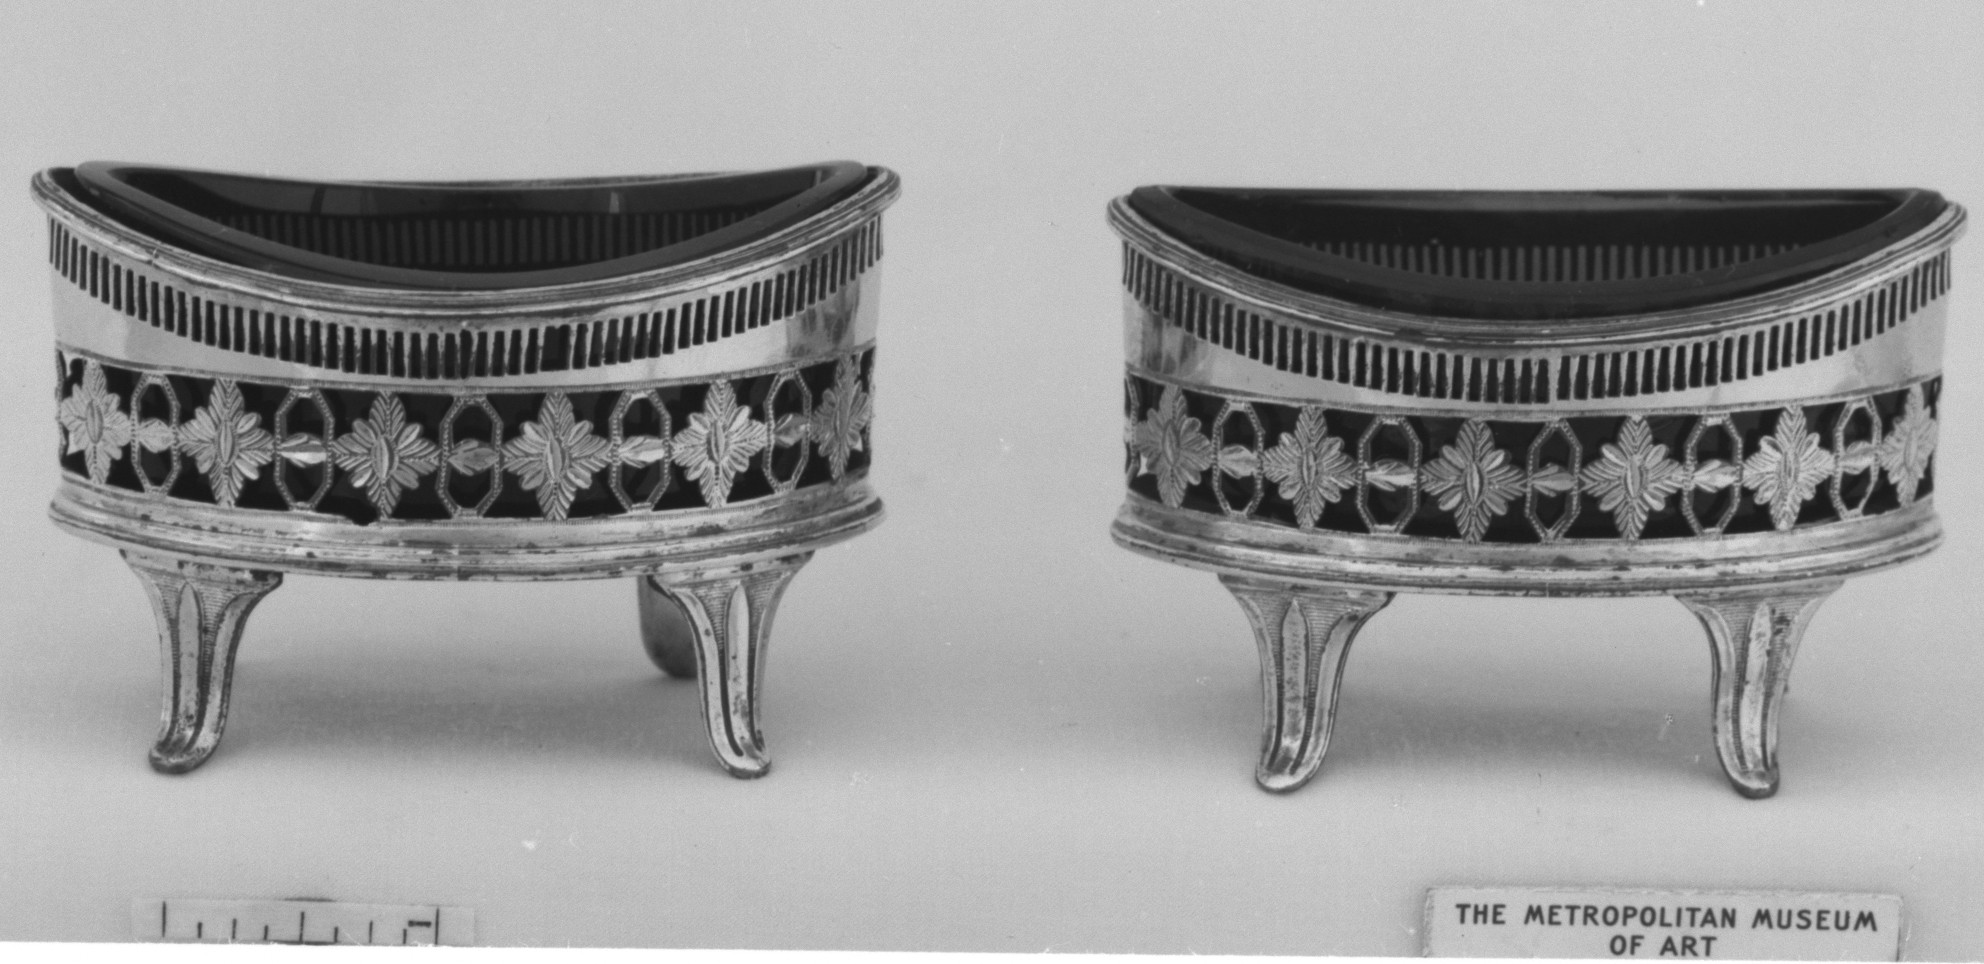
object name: saltcellar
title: Saltcellar (one of a pair)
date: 1785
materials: glass, metal